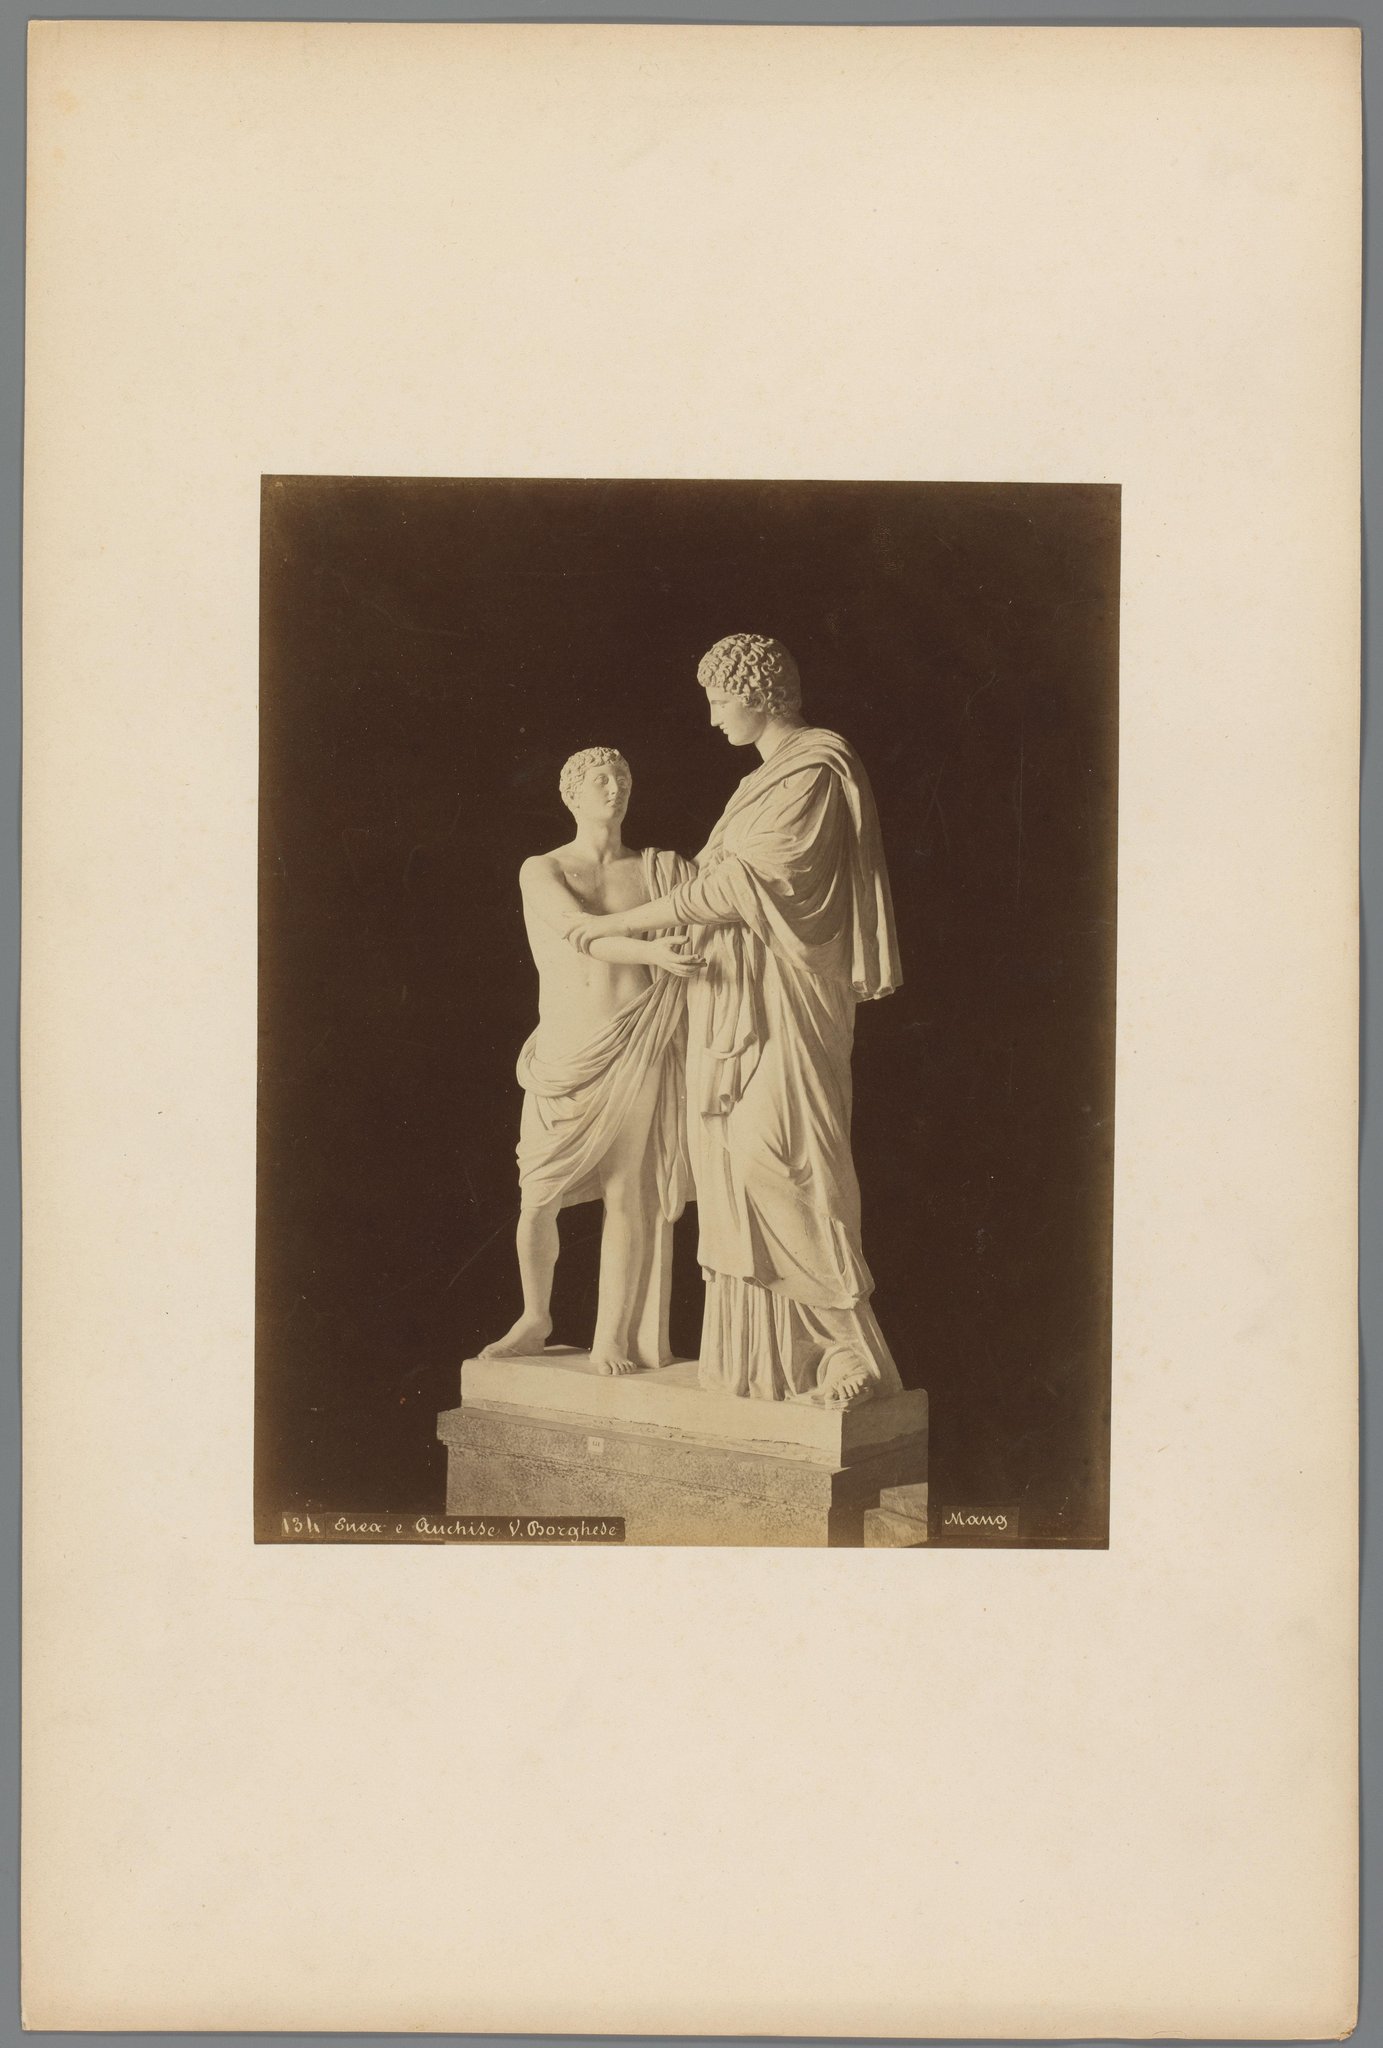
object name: photograph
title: Sculptuur van Oreste en Electra in het Palazzo Altemps te Rome, Italië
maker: michèle mang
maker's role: fotograaf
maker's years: 1840-1909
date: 1863-1887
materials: cardboard, paper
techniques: albumen print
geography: rome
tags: 95a(orestes) (story of) orestes, 92e223 electra (pleiad), piece of sculpture, reproduction of a piece of sculpture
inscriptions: number: ‘134’